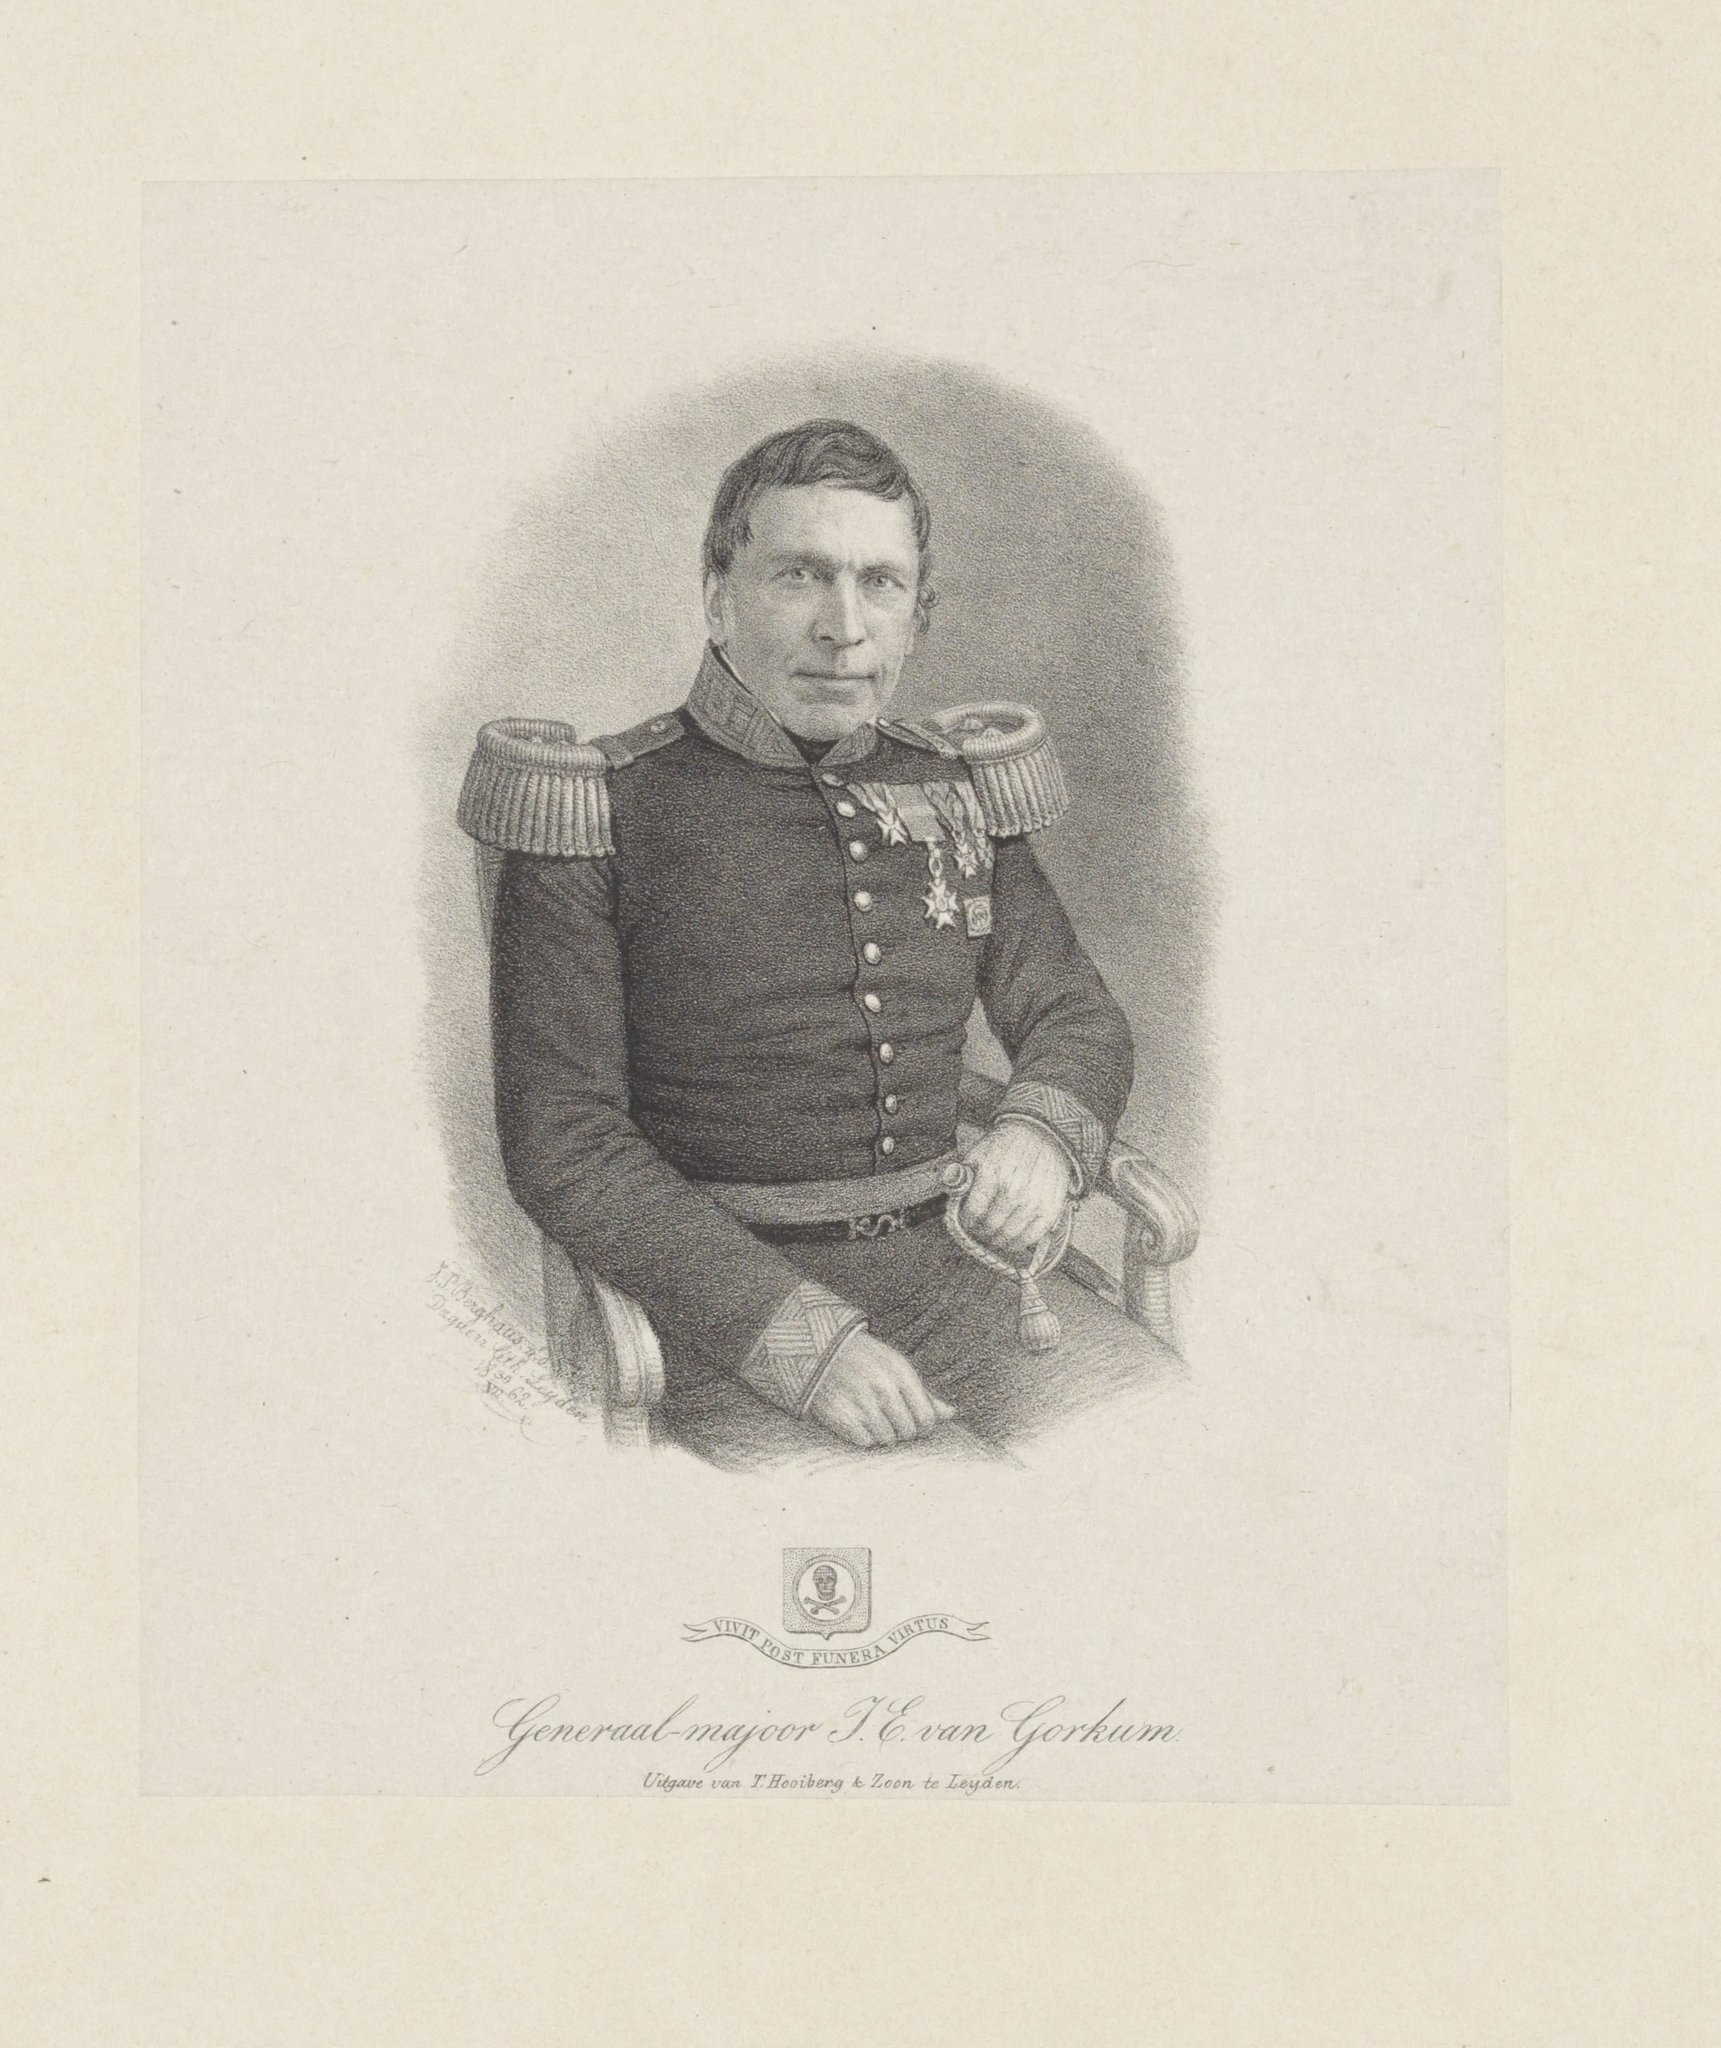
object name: print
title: Portret van Jan Egbert van Gorkum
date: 1862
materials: paper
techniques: lithograph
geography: leiden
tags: arnhem, draughtsman, knighthood order, hacking and thrusting weapons (with name), historical persons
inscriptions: inscription: ‘zoo helder / 8 de (...)vang van 60 afdr. op / dit papier, als de 260ste laatste (...)’, collector's mark: Lugt 2228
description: De geportretteerde draagt een militair uniform en zit op een stoel. In zijn linkerhand heeft hij een sabel. Hij draagt verschillende ridderorden op de borst. Onder het portret een schedel met daarbij de woorden: vivit post funera virtus.